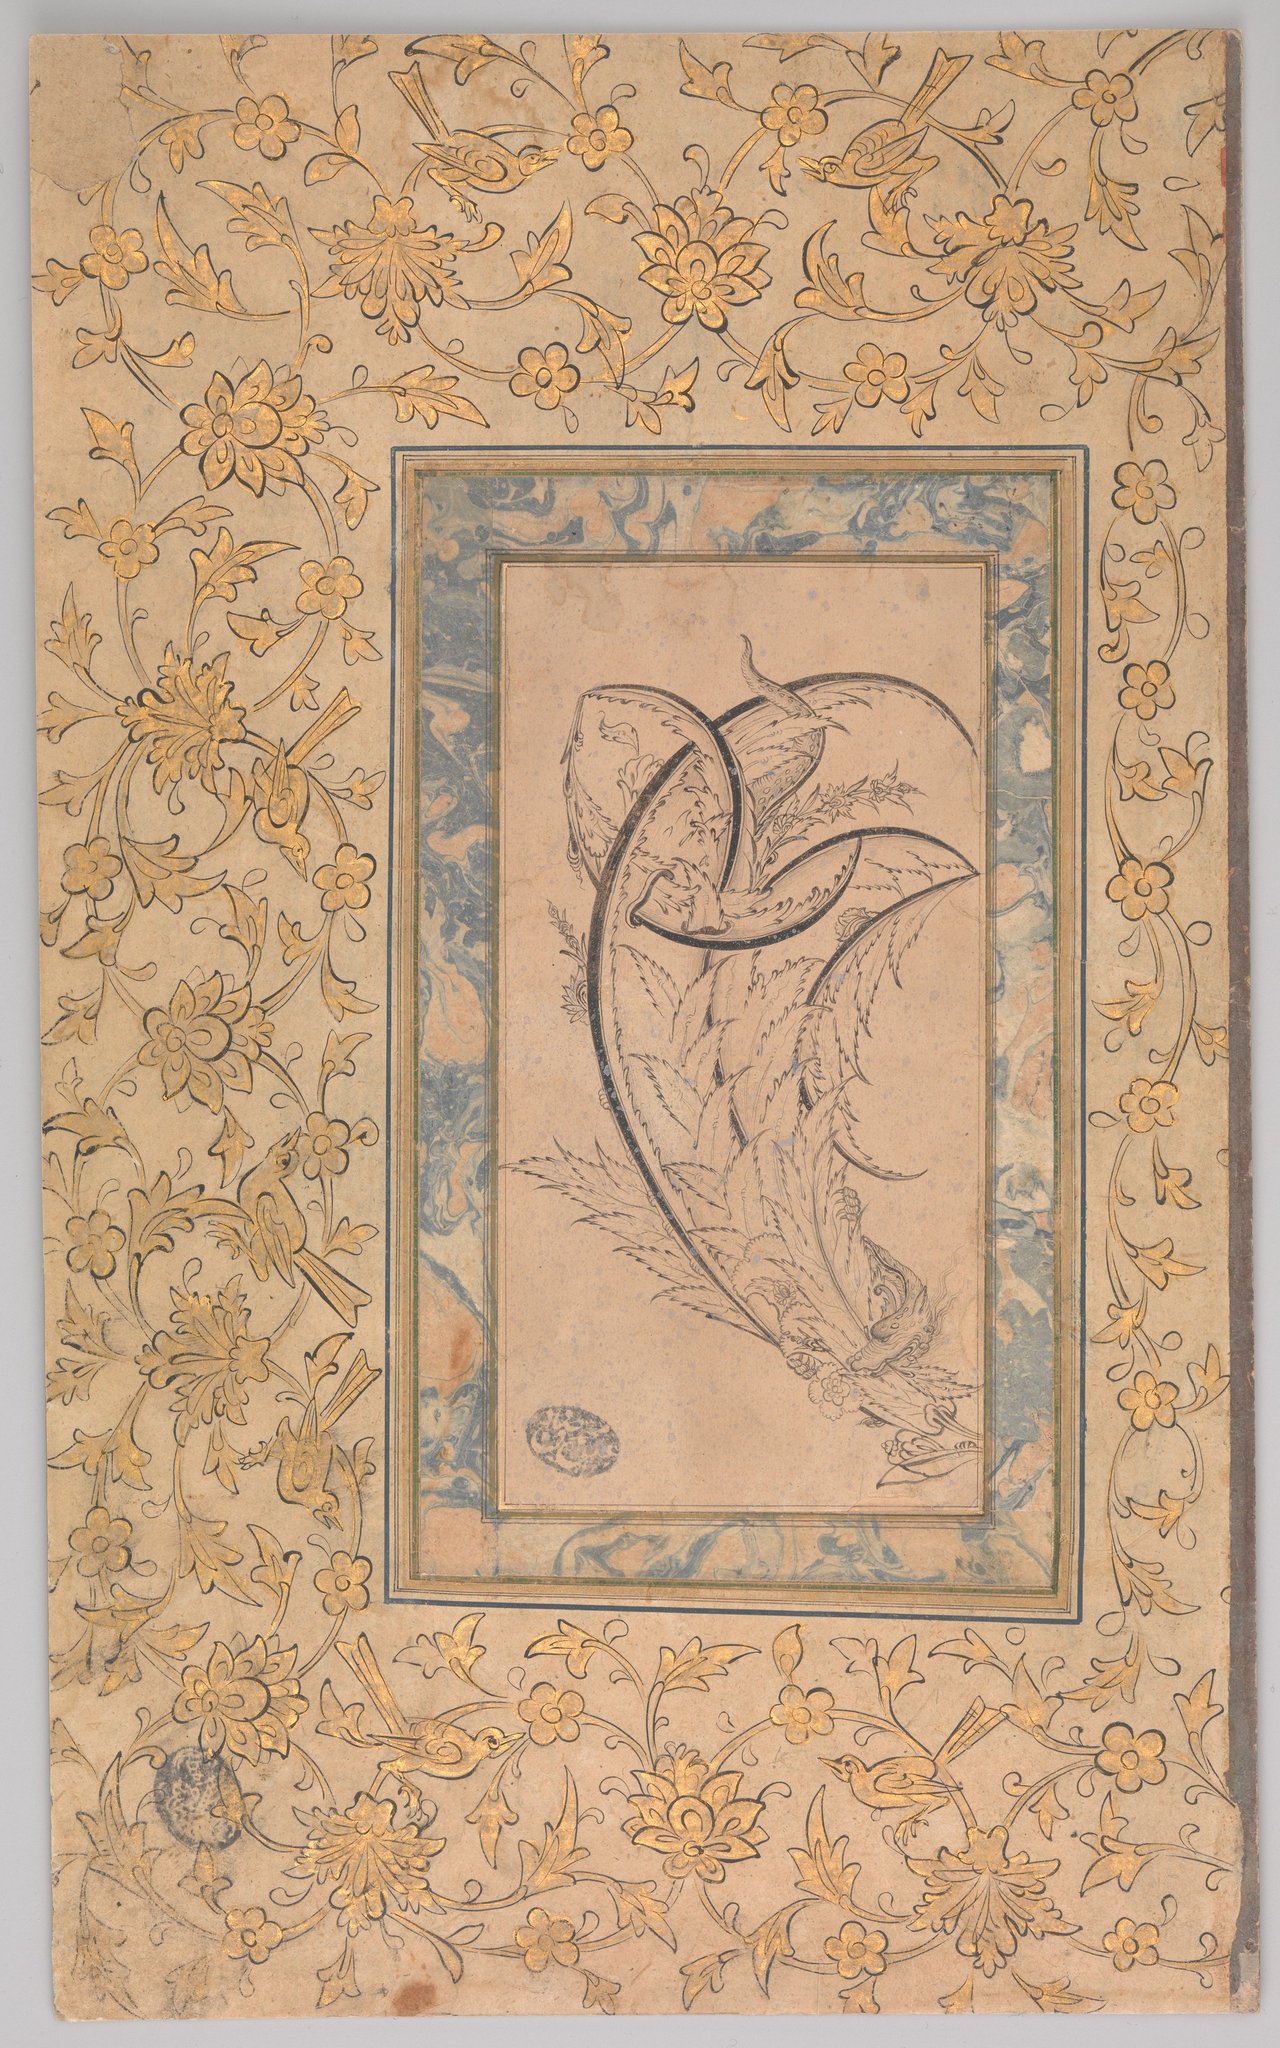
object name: iillustrated single work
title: Dragon Wrapped around Saz Leaves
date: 1550-1570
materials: gold, ink, paper, watercolor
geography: turkey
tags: birds,dragons,leaves